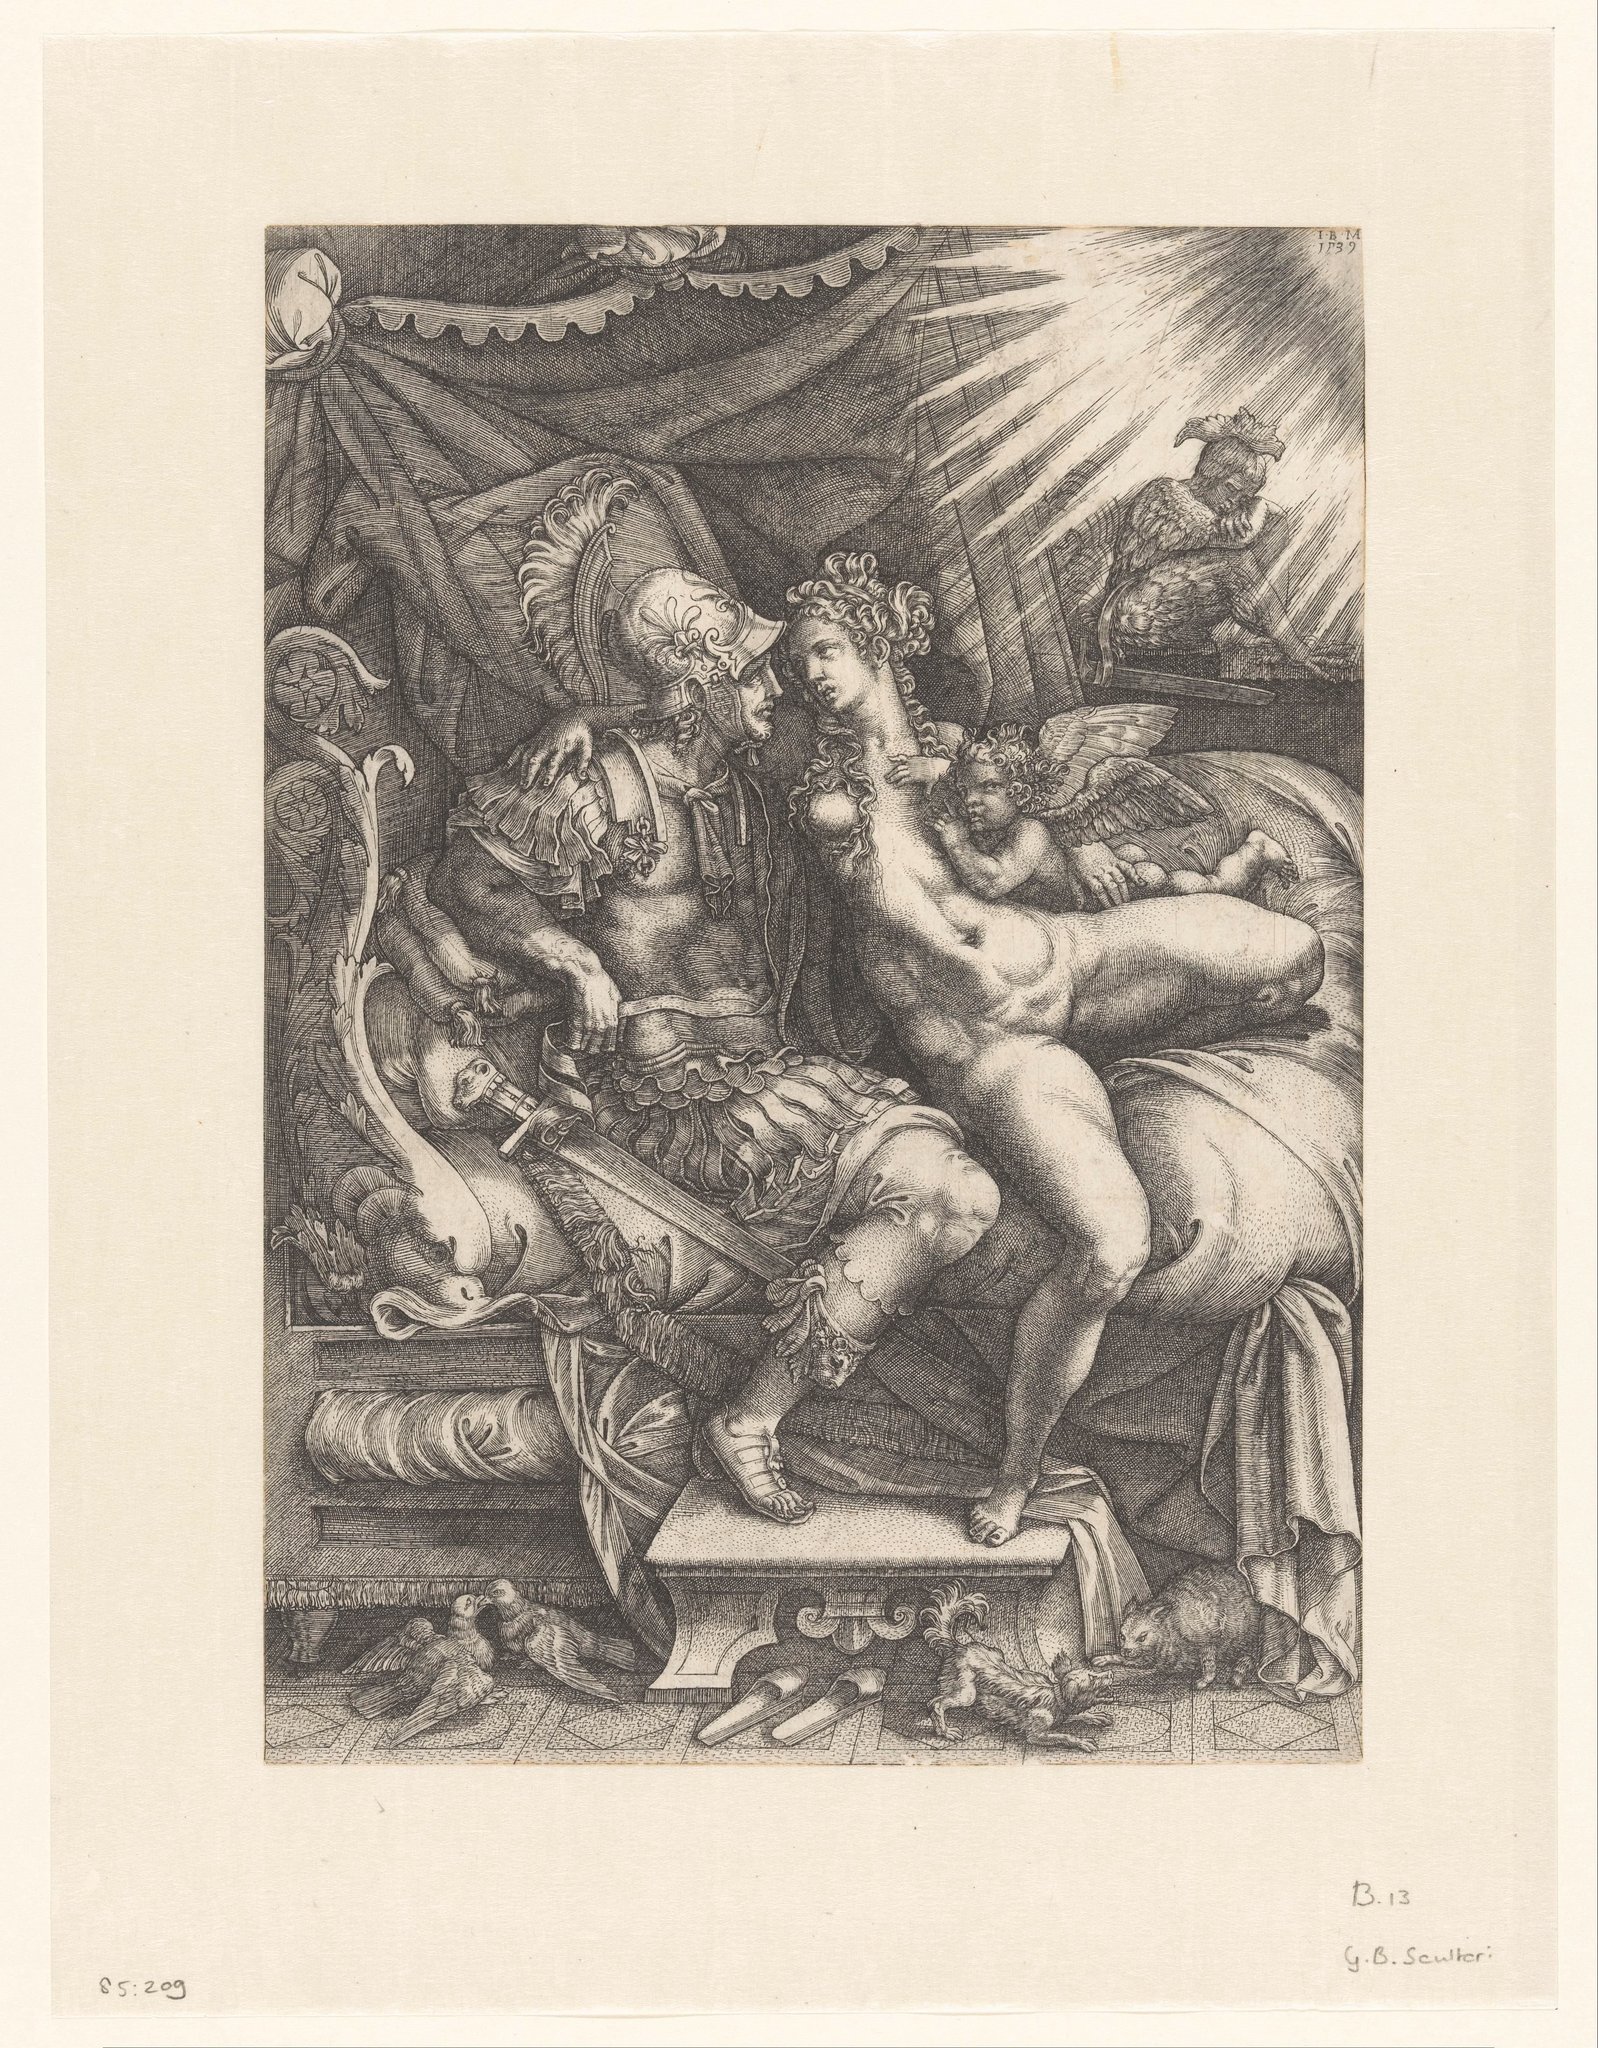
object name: print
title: Mars en Venus als geliefden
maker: giovanni battista scultori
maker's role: print maker, sculptor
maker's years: 1503-1575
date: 1539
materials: paper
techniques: engraving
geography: mantua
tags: mars and venus as lovers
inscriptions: collector's mark: Lugt 2760, collector's mark: Lugt 2228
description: Mars en Venus liggen op een bed, Venus is naakt en Mars gekleed in volle wapenrusting. Naast Venus ligt Amor. Op de voorgrond twee duiven, een kat en een hond. Rechts op de achtergrond zit in een raamkozijn een figuur met een gevederd lichaam en vogelpoten.